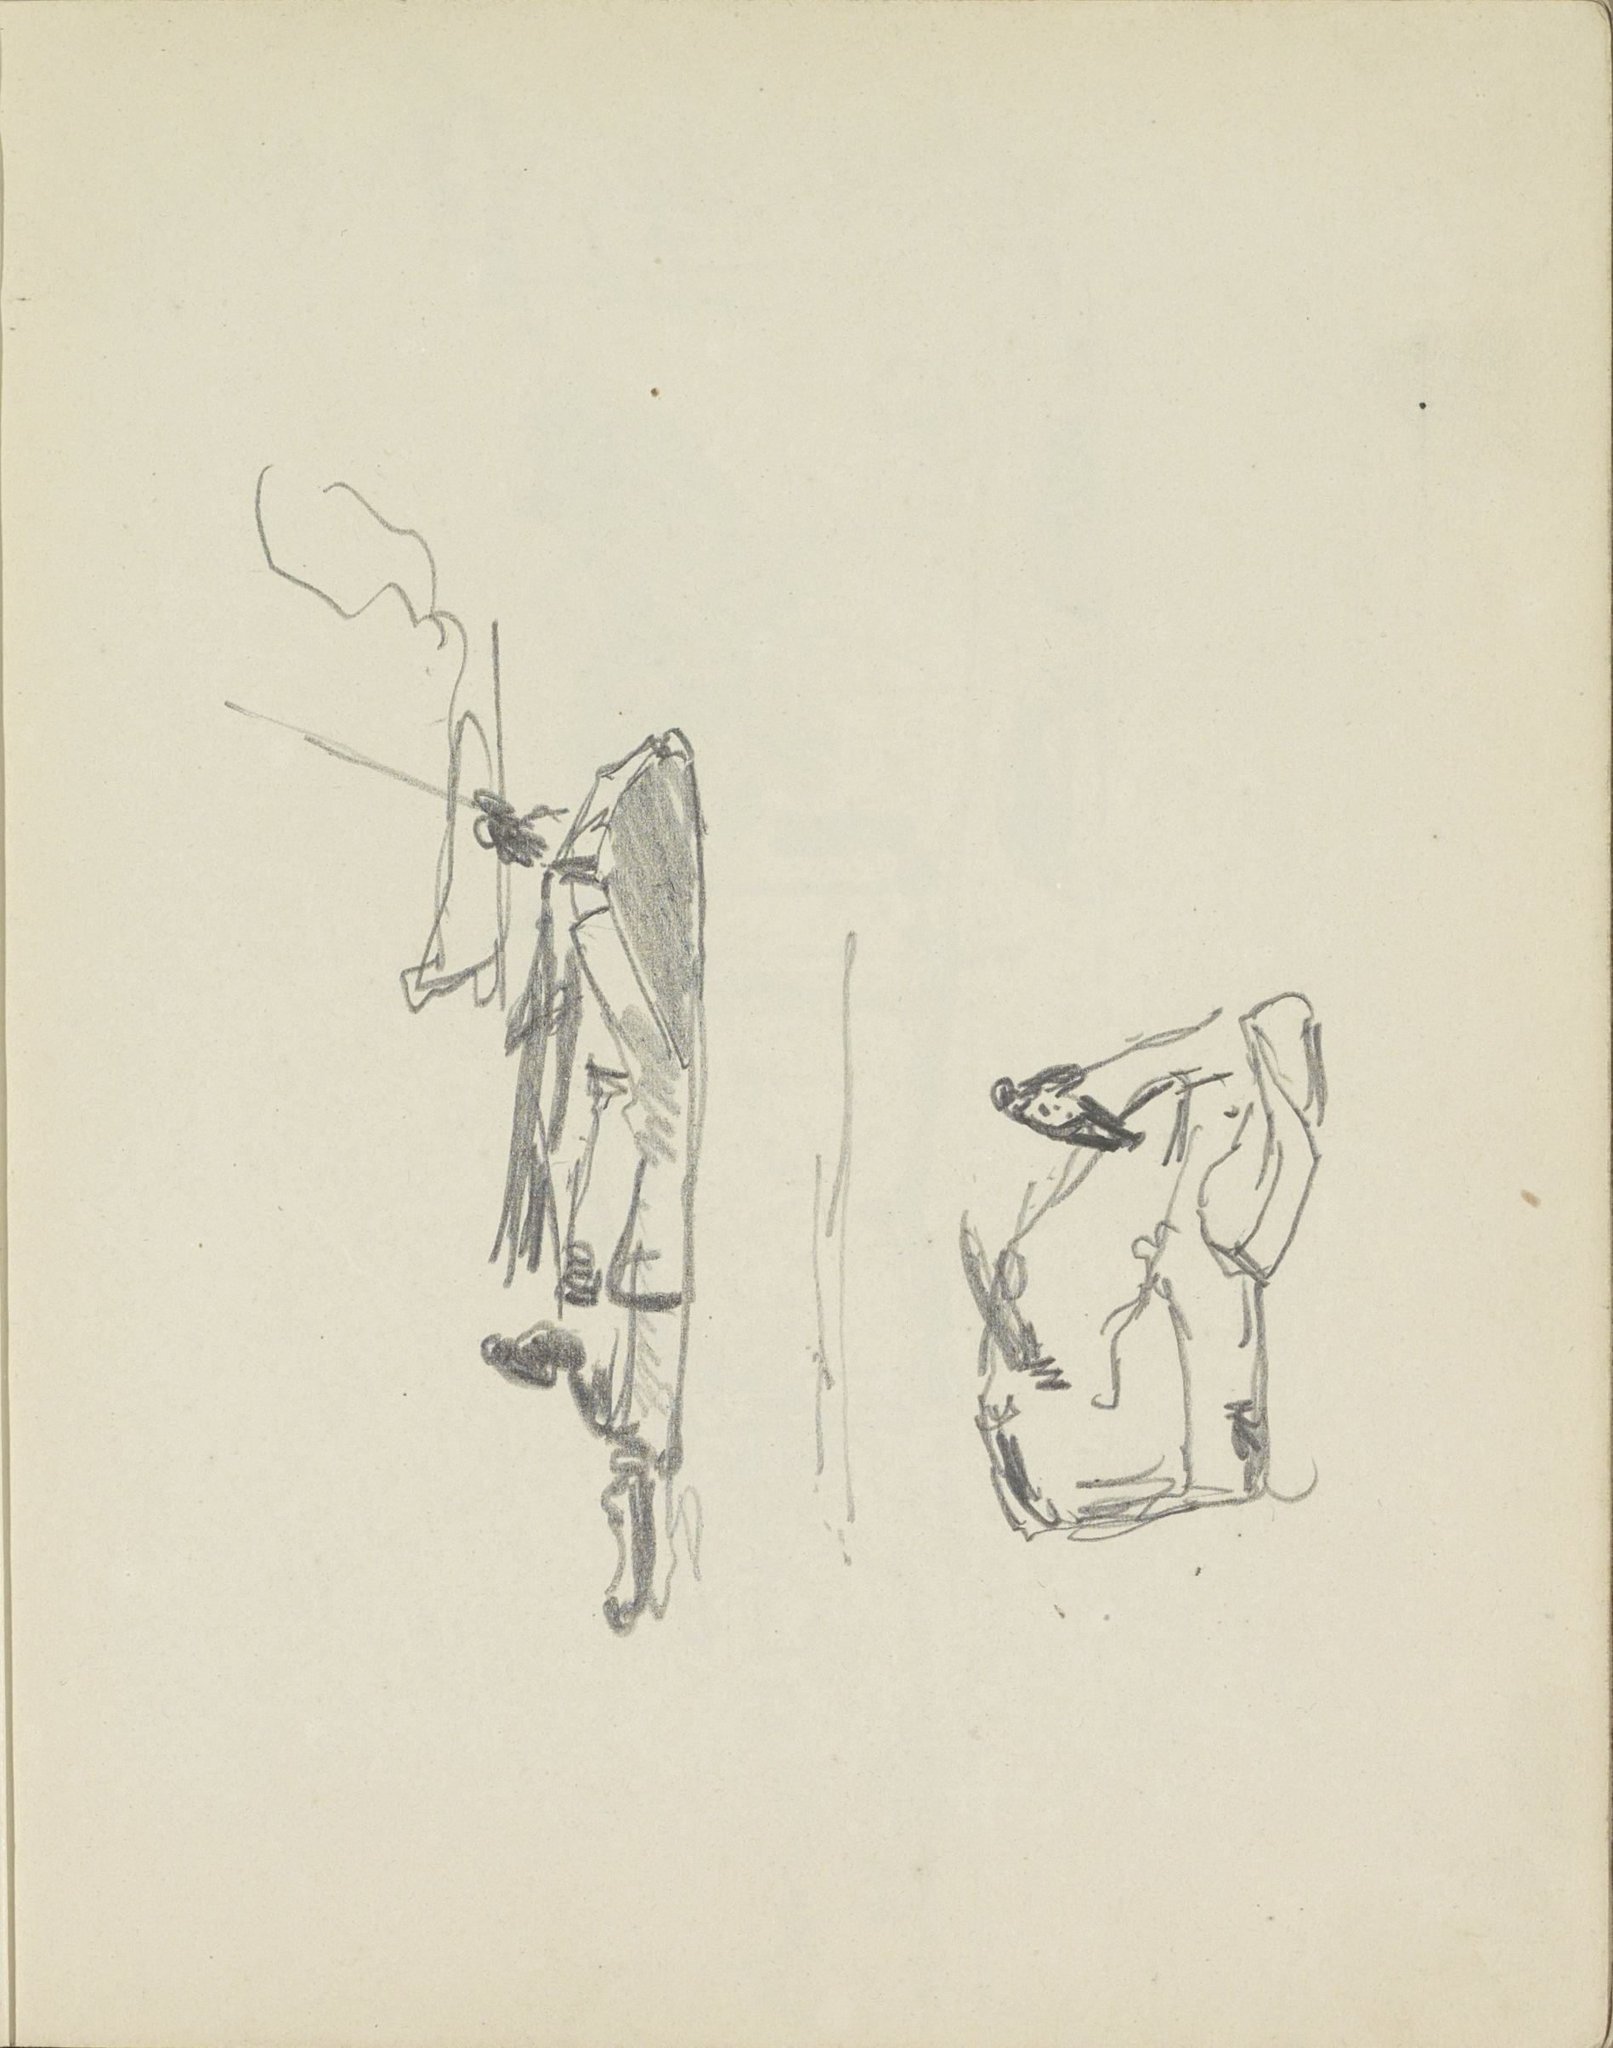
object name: sketchbook leaf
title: Figuren op een boot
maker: cornelis vreedenburgh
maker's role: draughtsman, print maker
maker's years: 1880-1946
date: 1890-1946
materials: paper, pencil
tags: sailing-ship, sailing-boat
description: Blad 3 recto uit een schetsboek met 76 bladen.